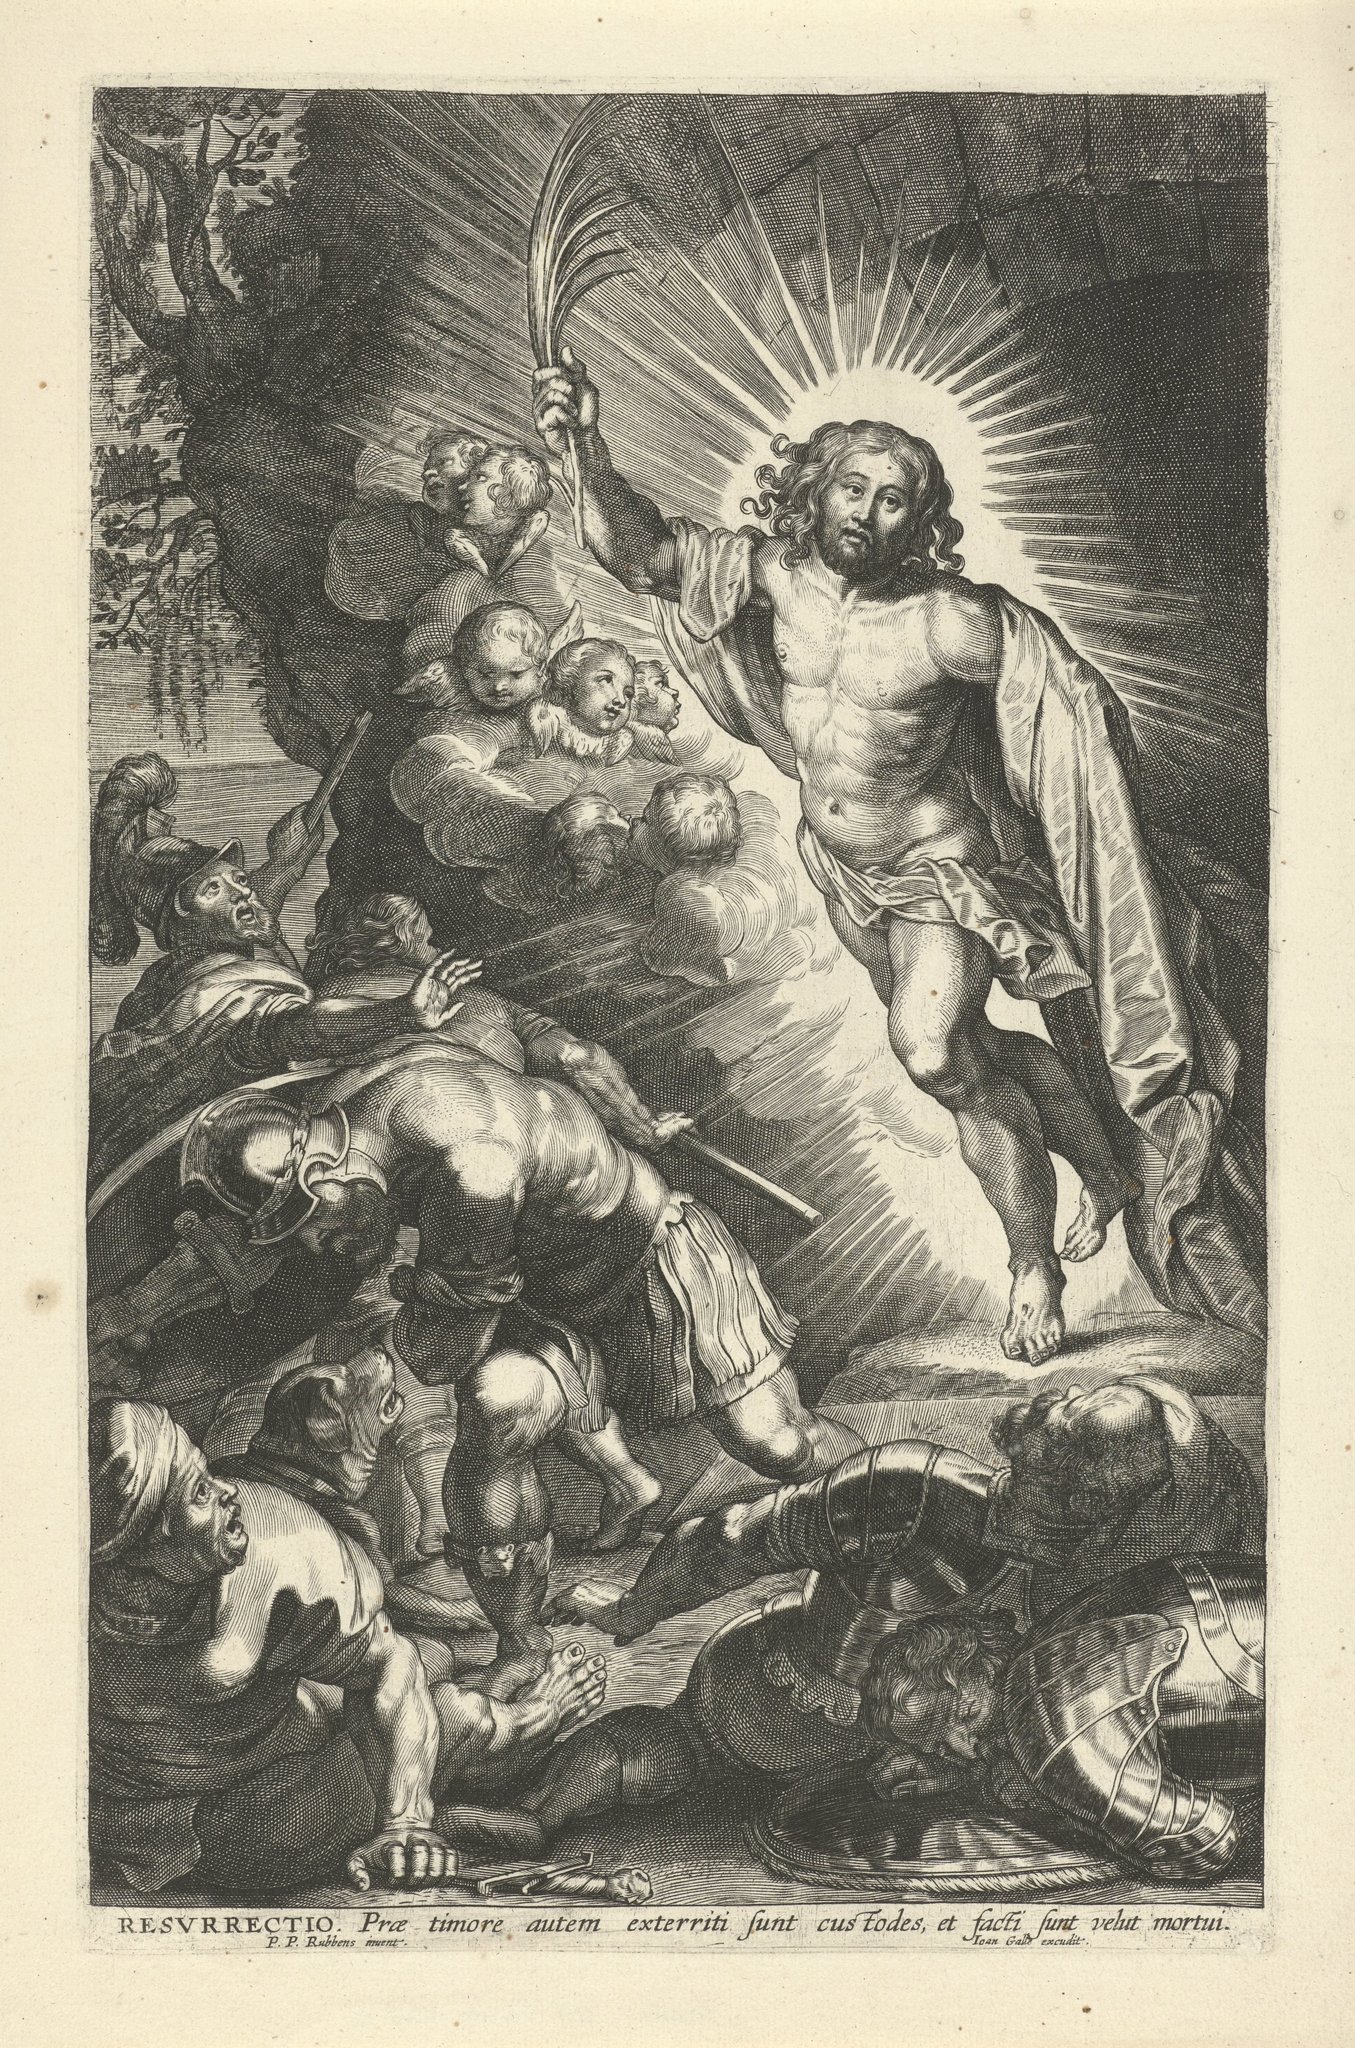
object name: print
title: Opstanding van Christus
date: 1614-1676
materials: paper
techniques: engraving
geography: antwerp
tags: christ, usually holding a banner, arises from the grave; often combined with sleeping and/or frightened soldiers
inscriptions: collector's mark: Lugt 240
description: Christus verrijst uit zijn graf. Rondom hem engelen. De slapende soldaten schrikken wakker en slaan op de vlucht. De prent heeft een Latijns onderschrift.